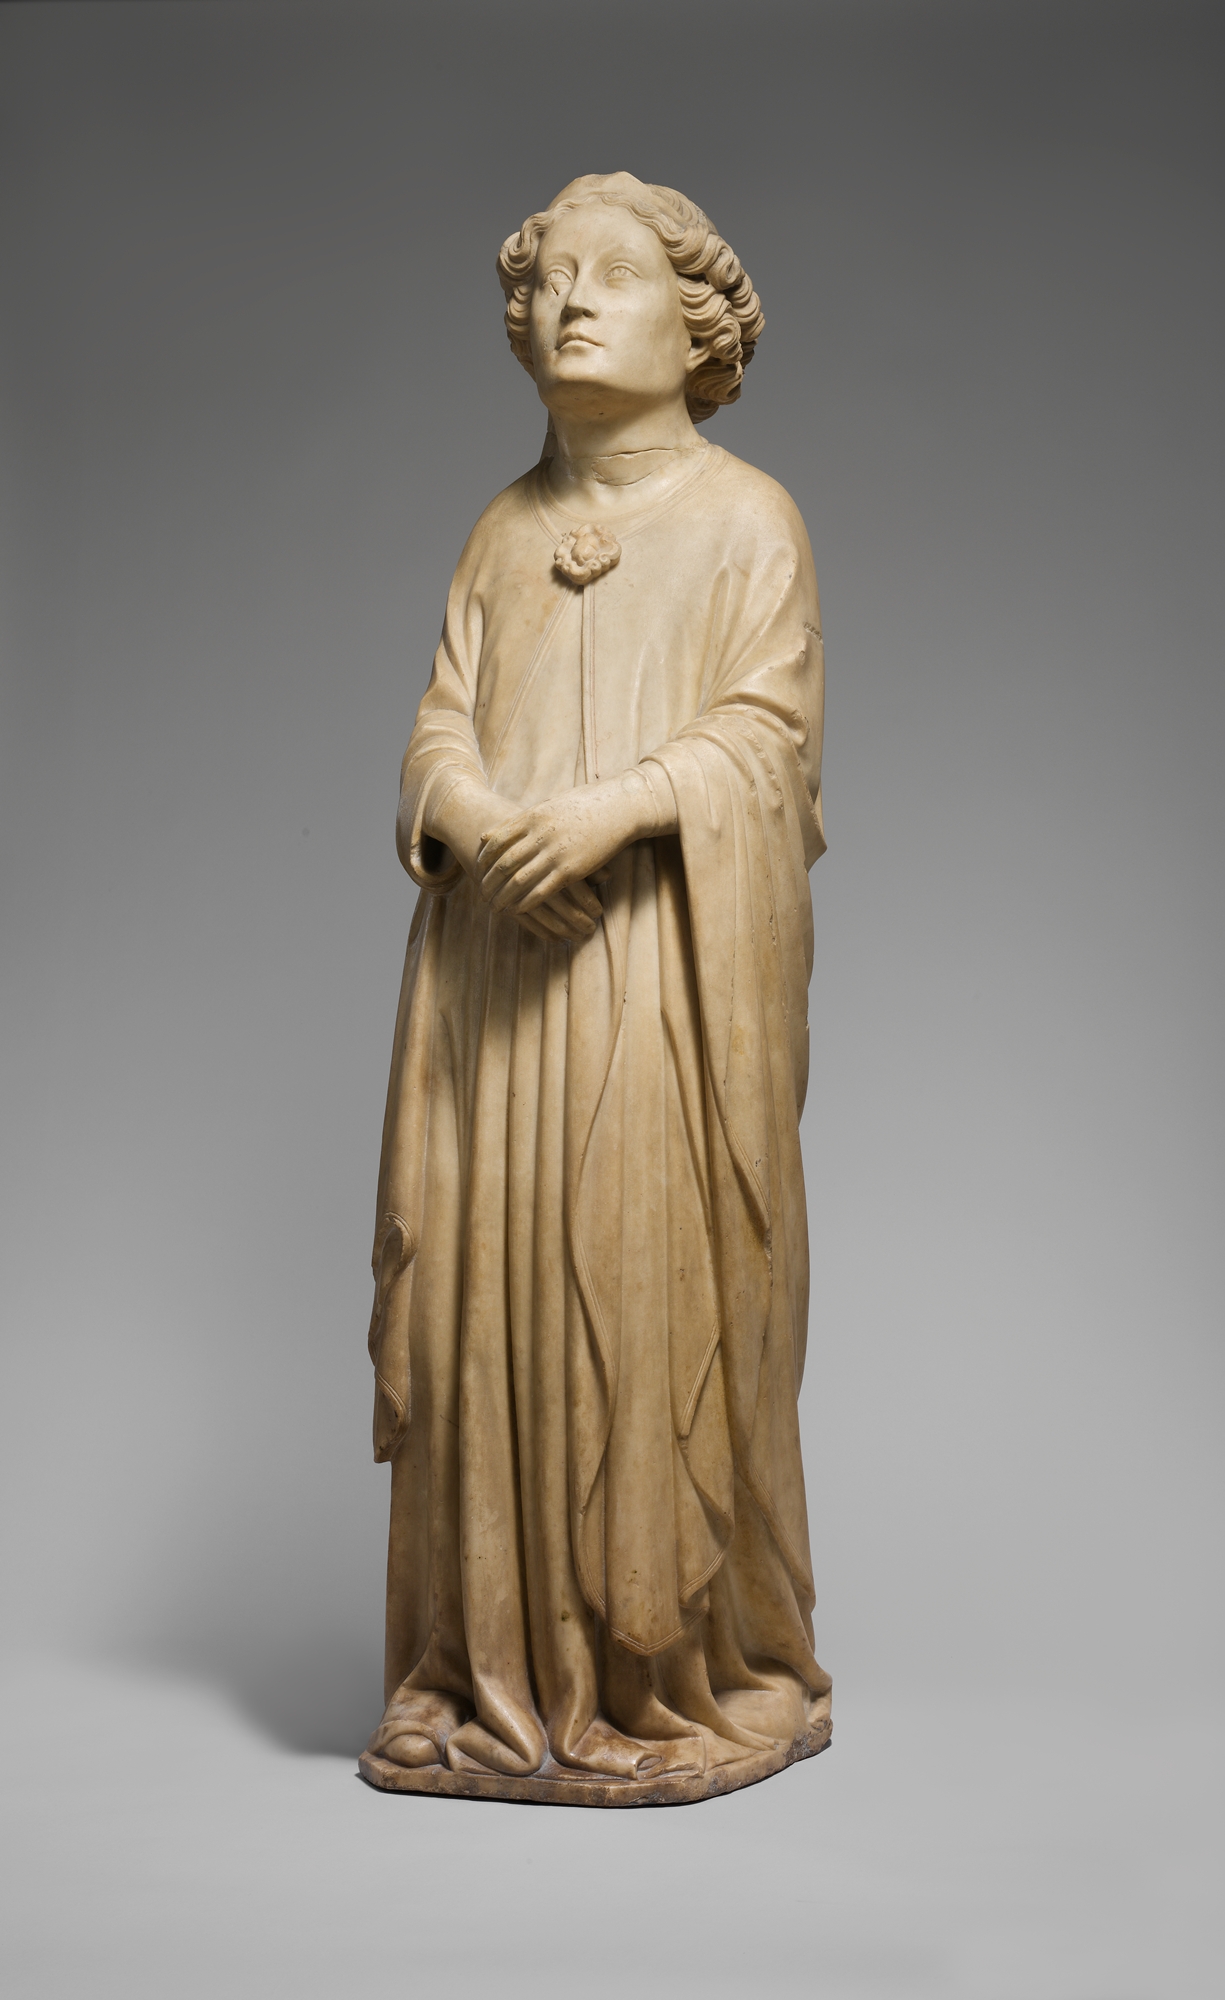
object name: statue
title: Adoring Angel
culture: central italian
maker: piero di giovanni tedesco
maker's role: artist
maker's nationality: italian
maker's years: -1402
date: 1395-1396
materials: marble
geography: italy